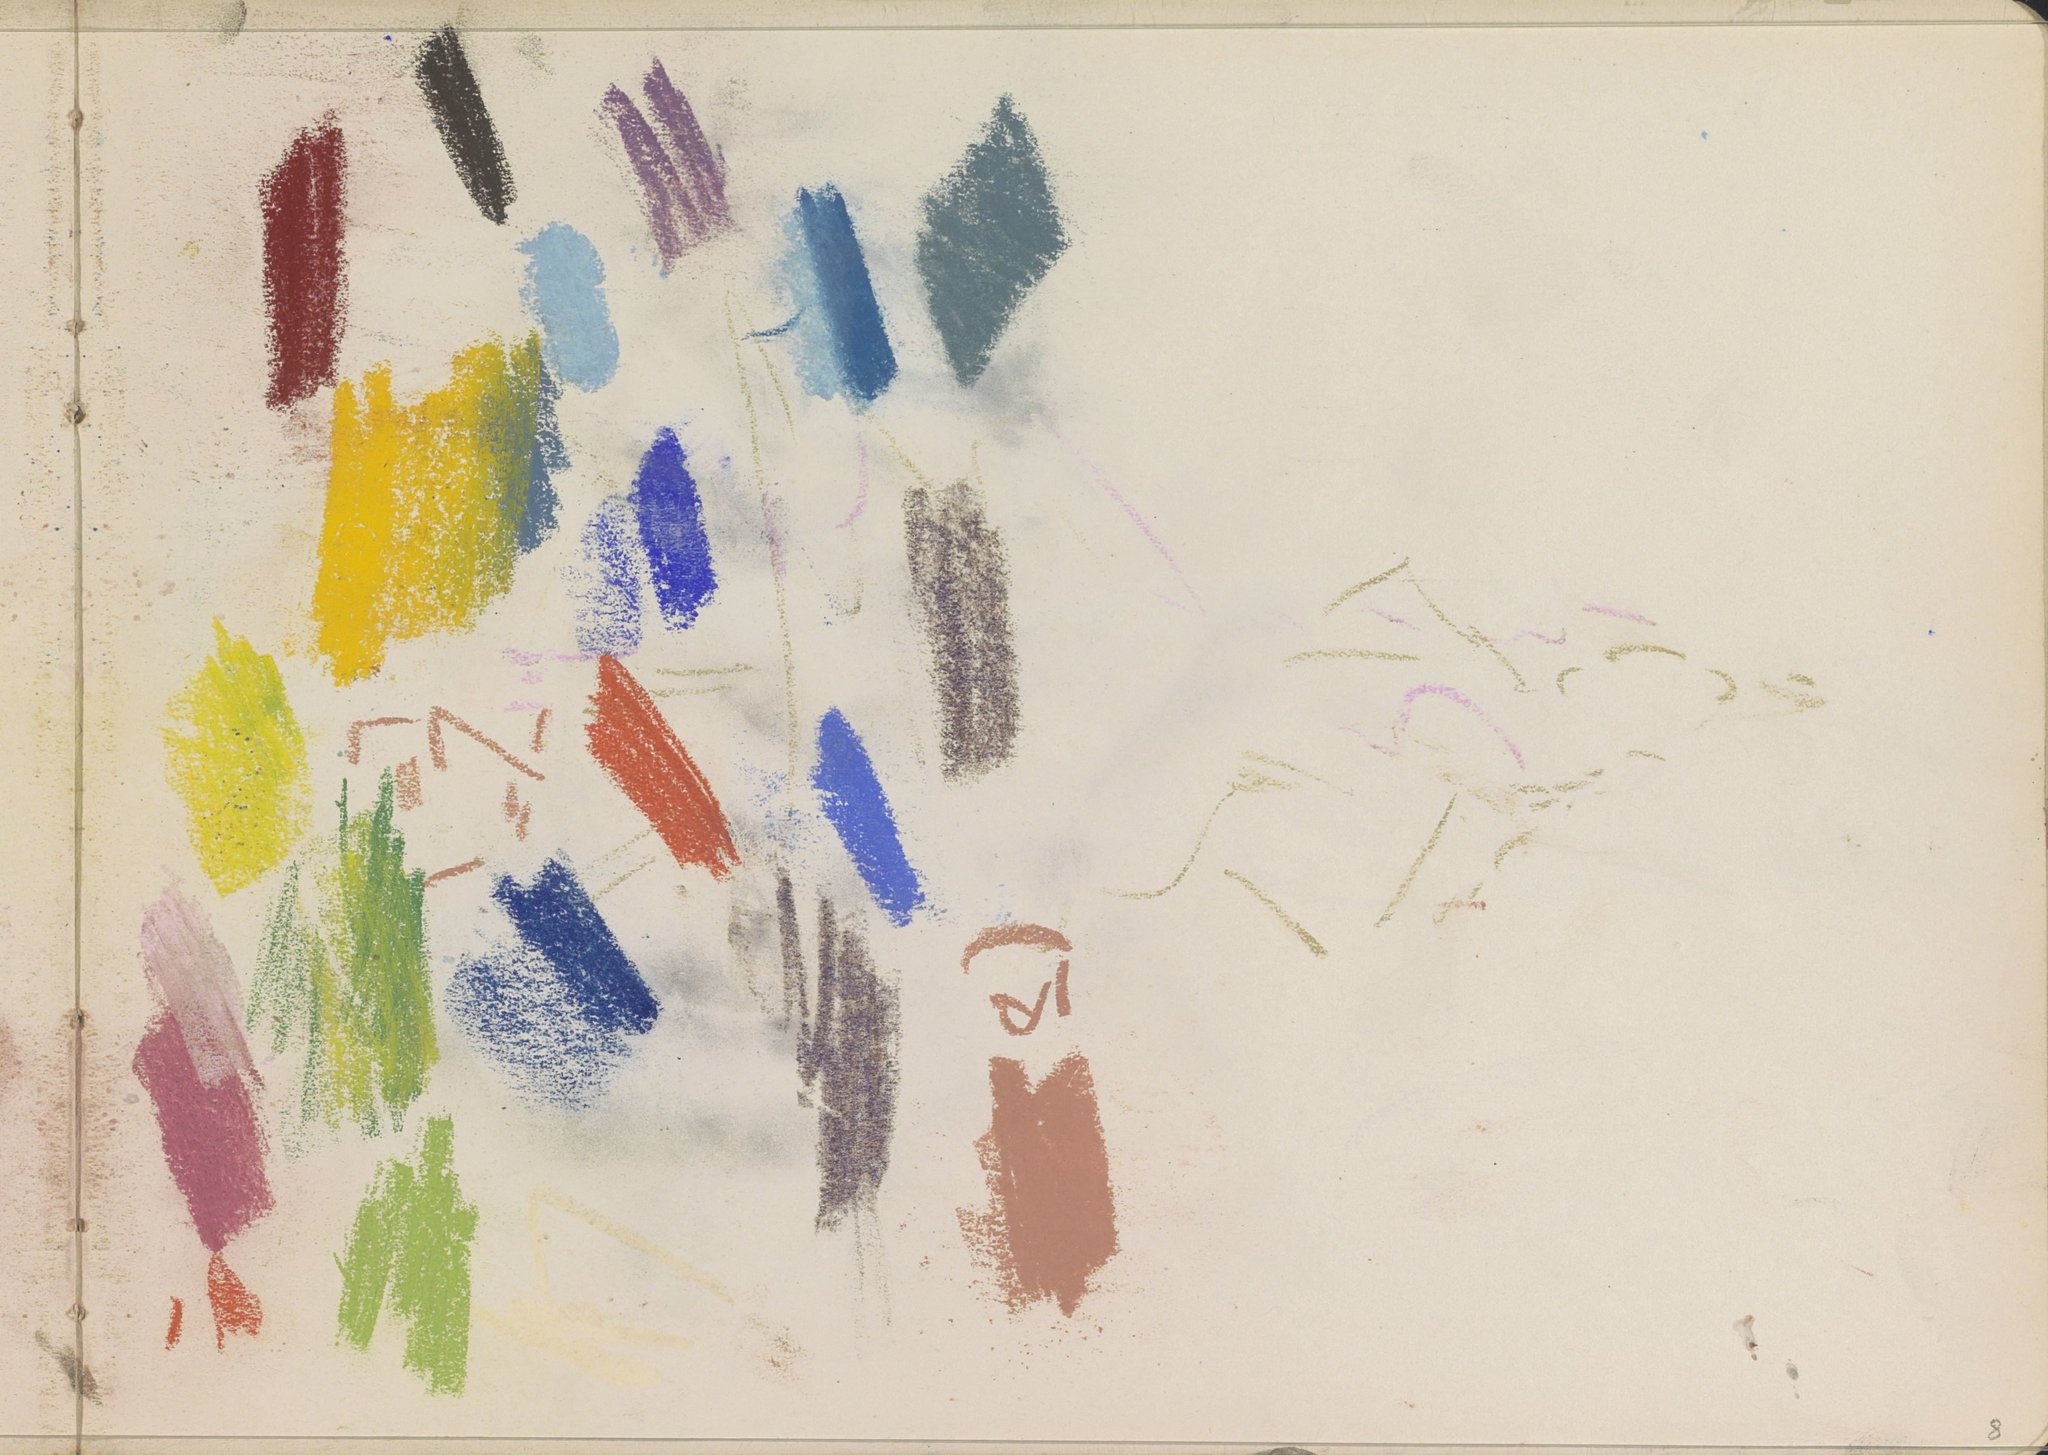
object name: sketchbook leaf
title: Staande vrouw, mogelijk een revuedanseres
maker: isaac israels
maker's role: draughtsman, painter, print maker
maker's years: 1865-1934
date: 1915-1934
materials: chalk, paper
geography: the hague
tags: female dancer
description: Blad 8 recto uit schetsboek VI met 33 bladen.